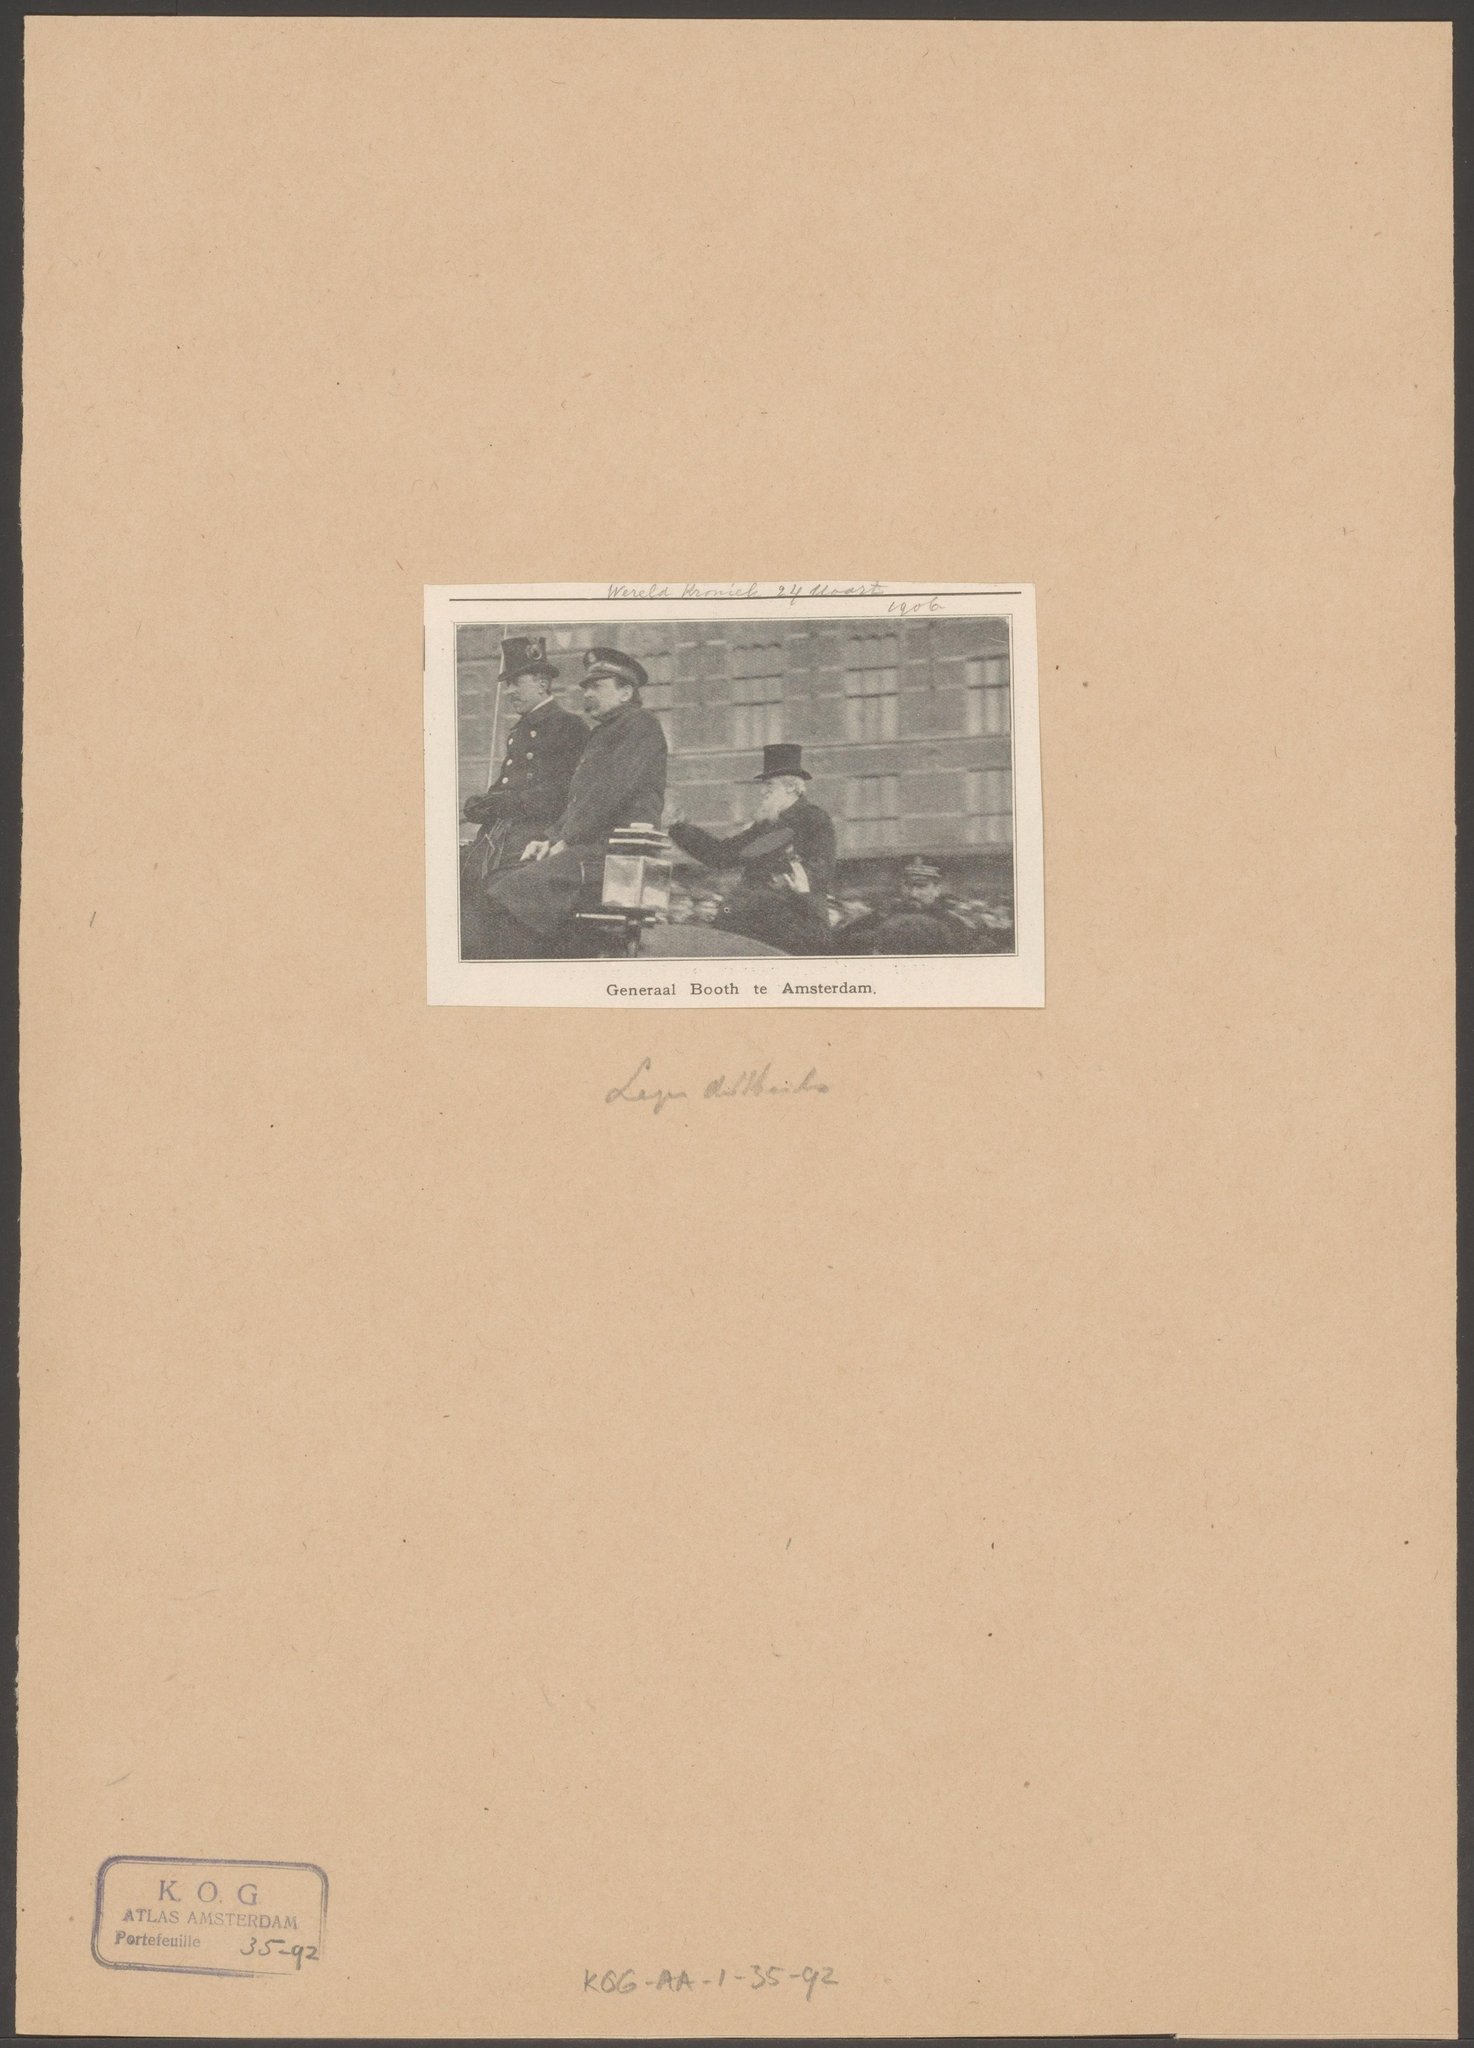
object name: photomechanical print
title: William Booth te Amsterdam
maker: Anonymous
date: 1906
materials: paper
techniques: letterpress printing, line block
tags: salvation army, historical person (with name)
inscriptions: collector's mark: ‘35-92’ Lugt 1641b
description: Onderwerpsrubriek binnen de Atlas Amsterdam: R.K. Gemeenten: Leger des Heils.